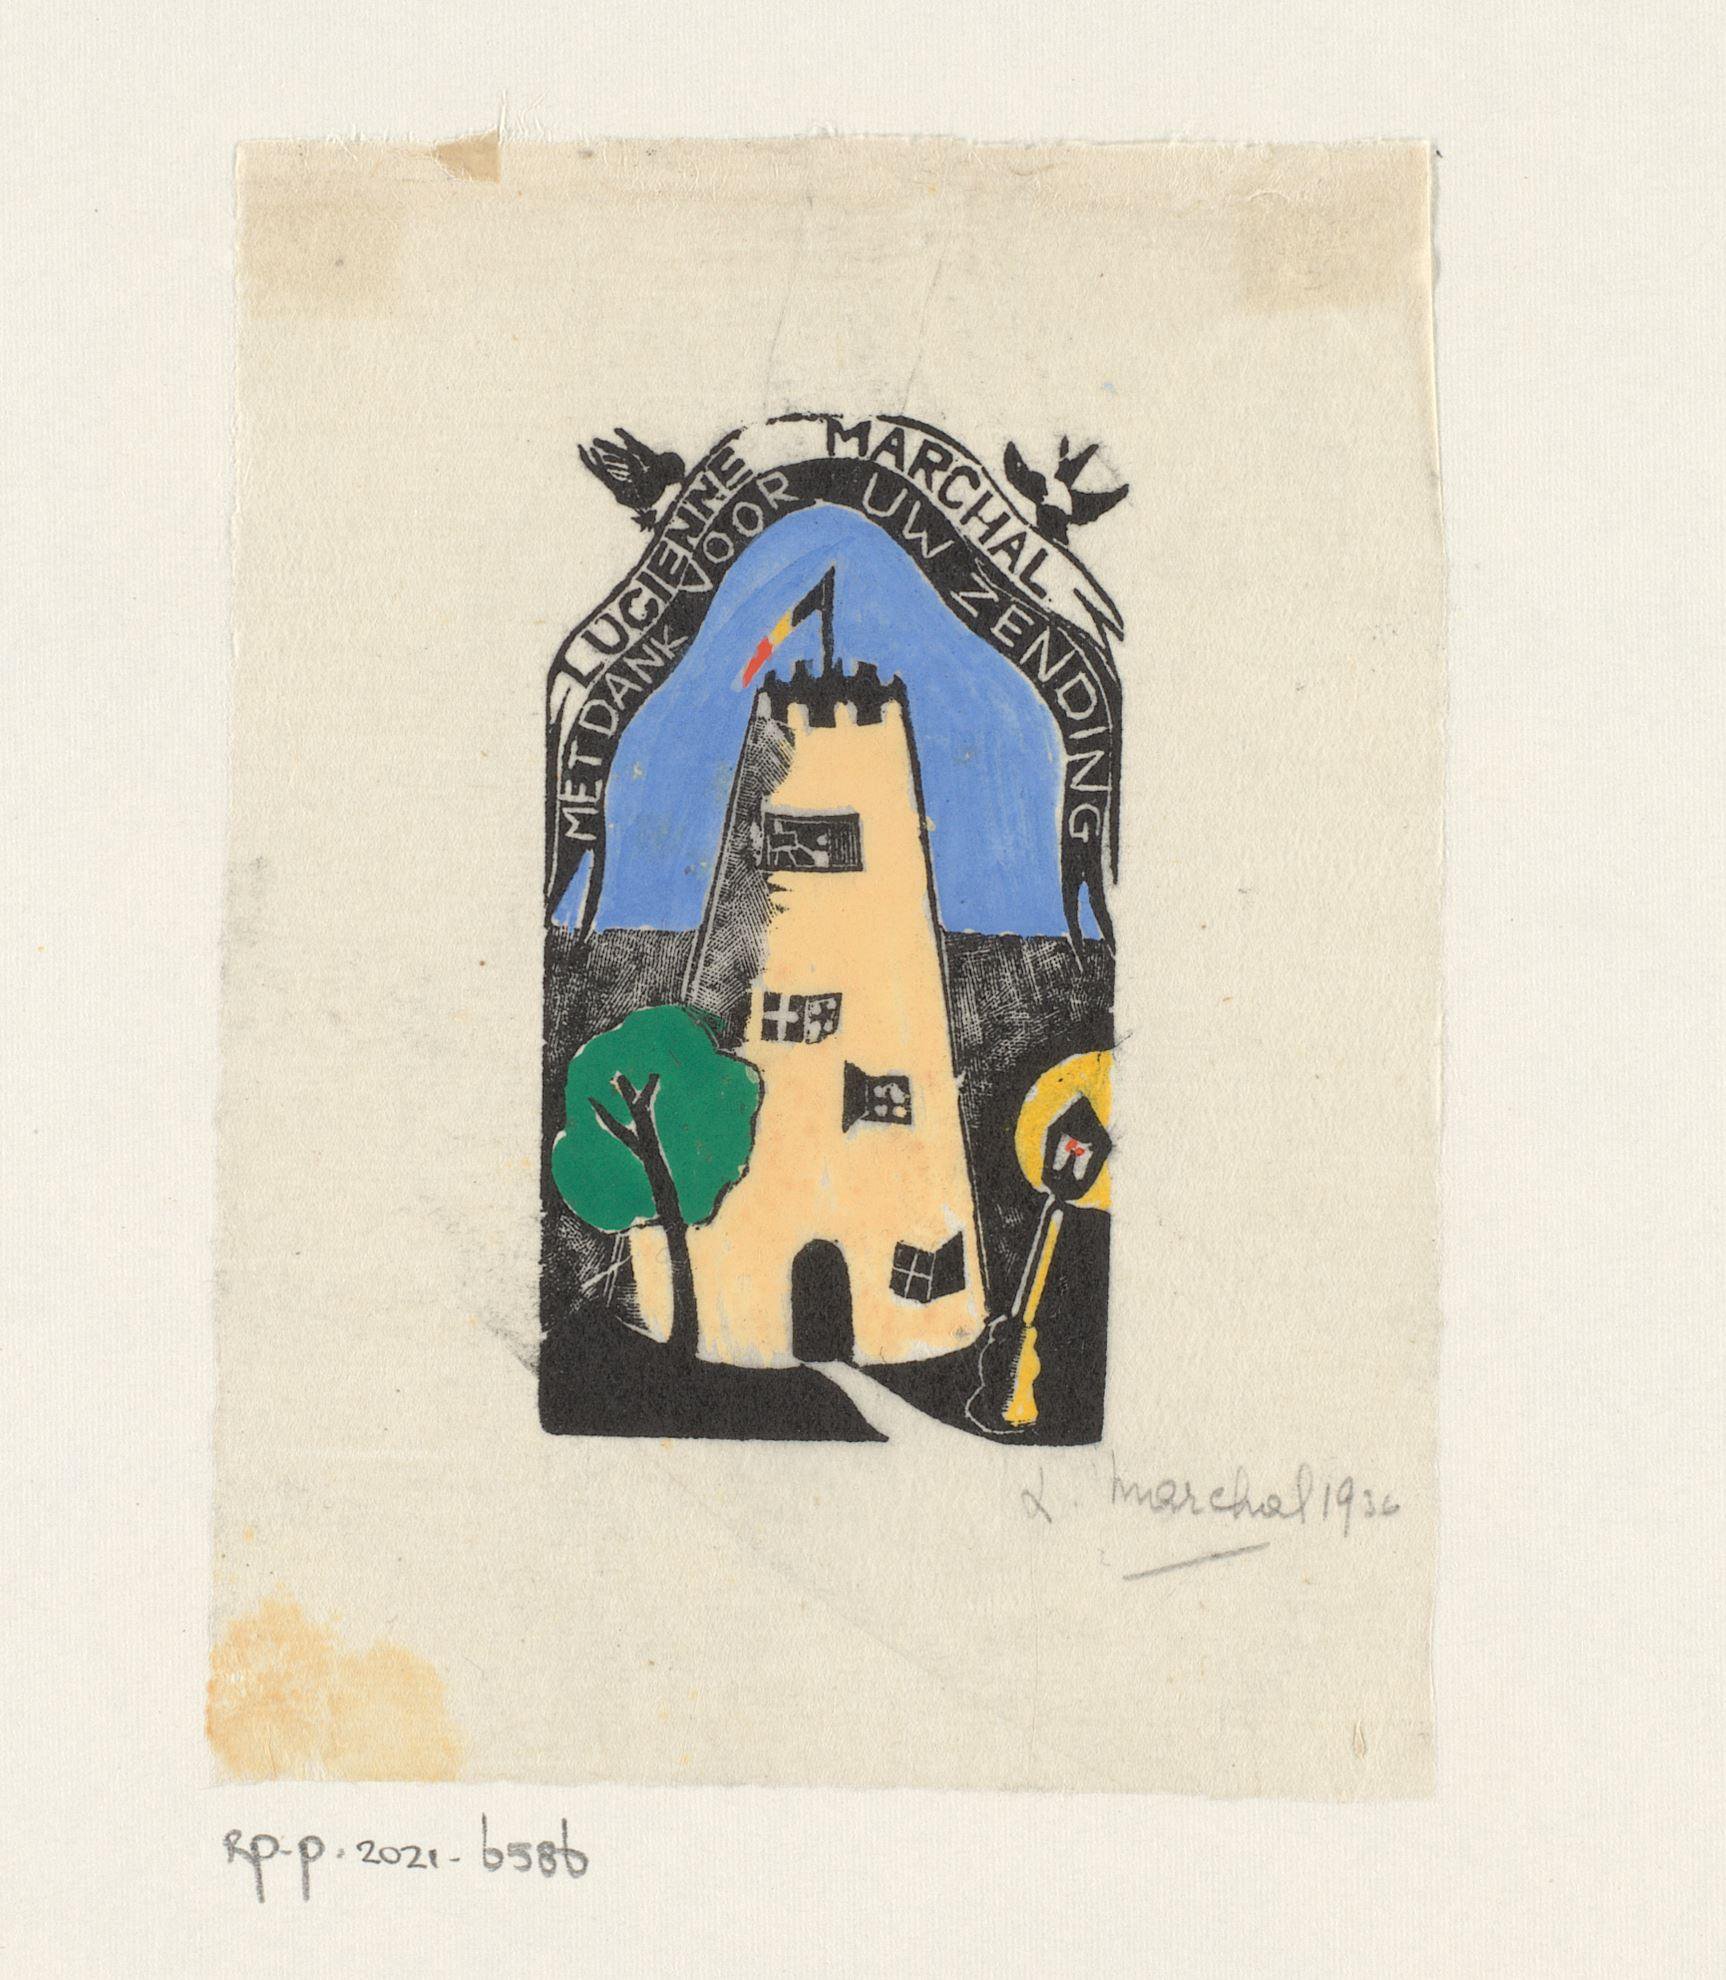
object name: print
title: Bedankkaart van Lucienne Marchal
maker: lucienne marchal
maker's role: print maker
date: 1936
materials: paper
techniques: hand coloring, engraving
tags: print maker, lucienne marchal, landscape with tower or castle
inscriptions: date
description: Bij gebrek aan gegevens over de vervaardiger is voor de bepaling van de rechten van dit object gebruik gemaakt van de vervaardigingsdatum.